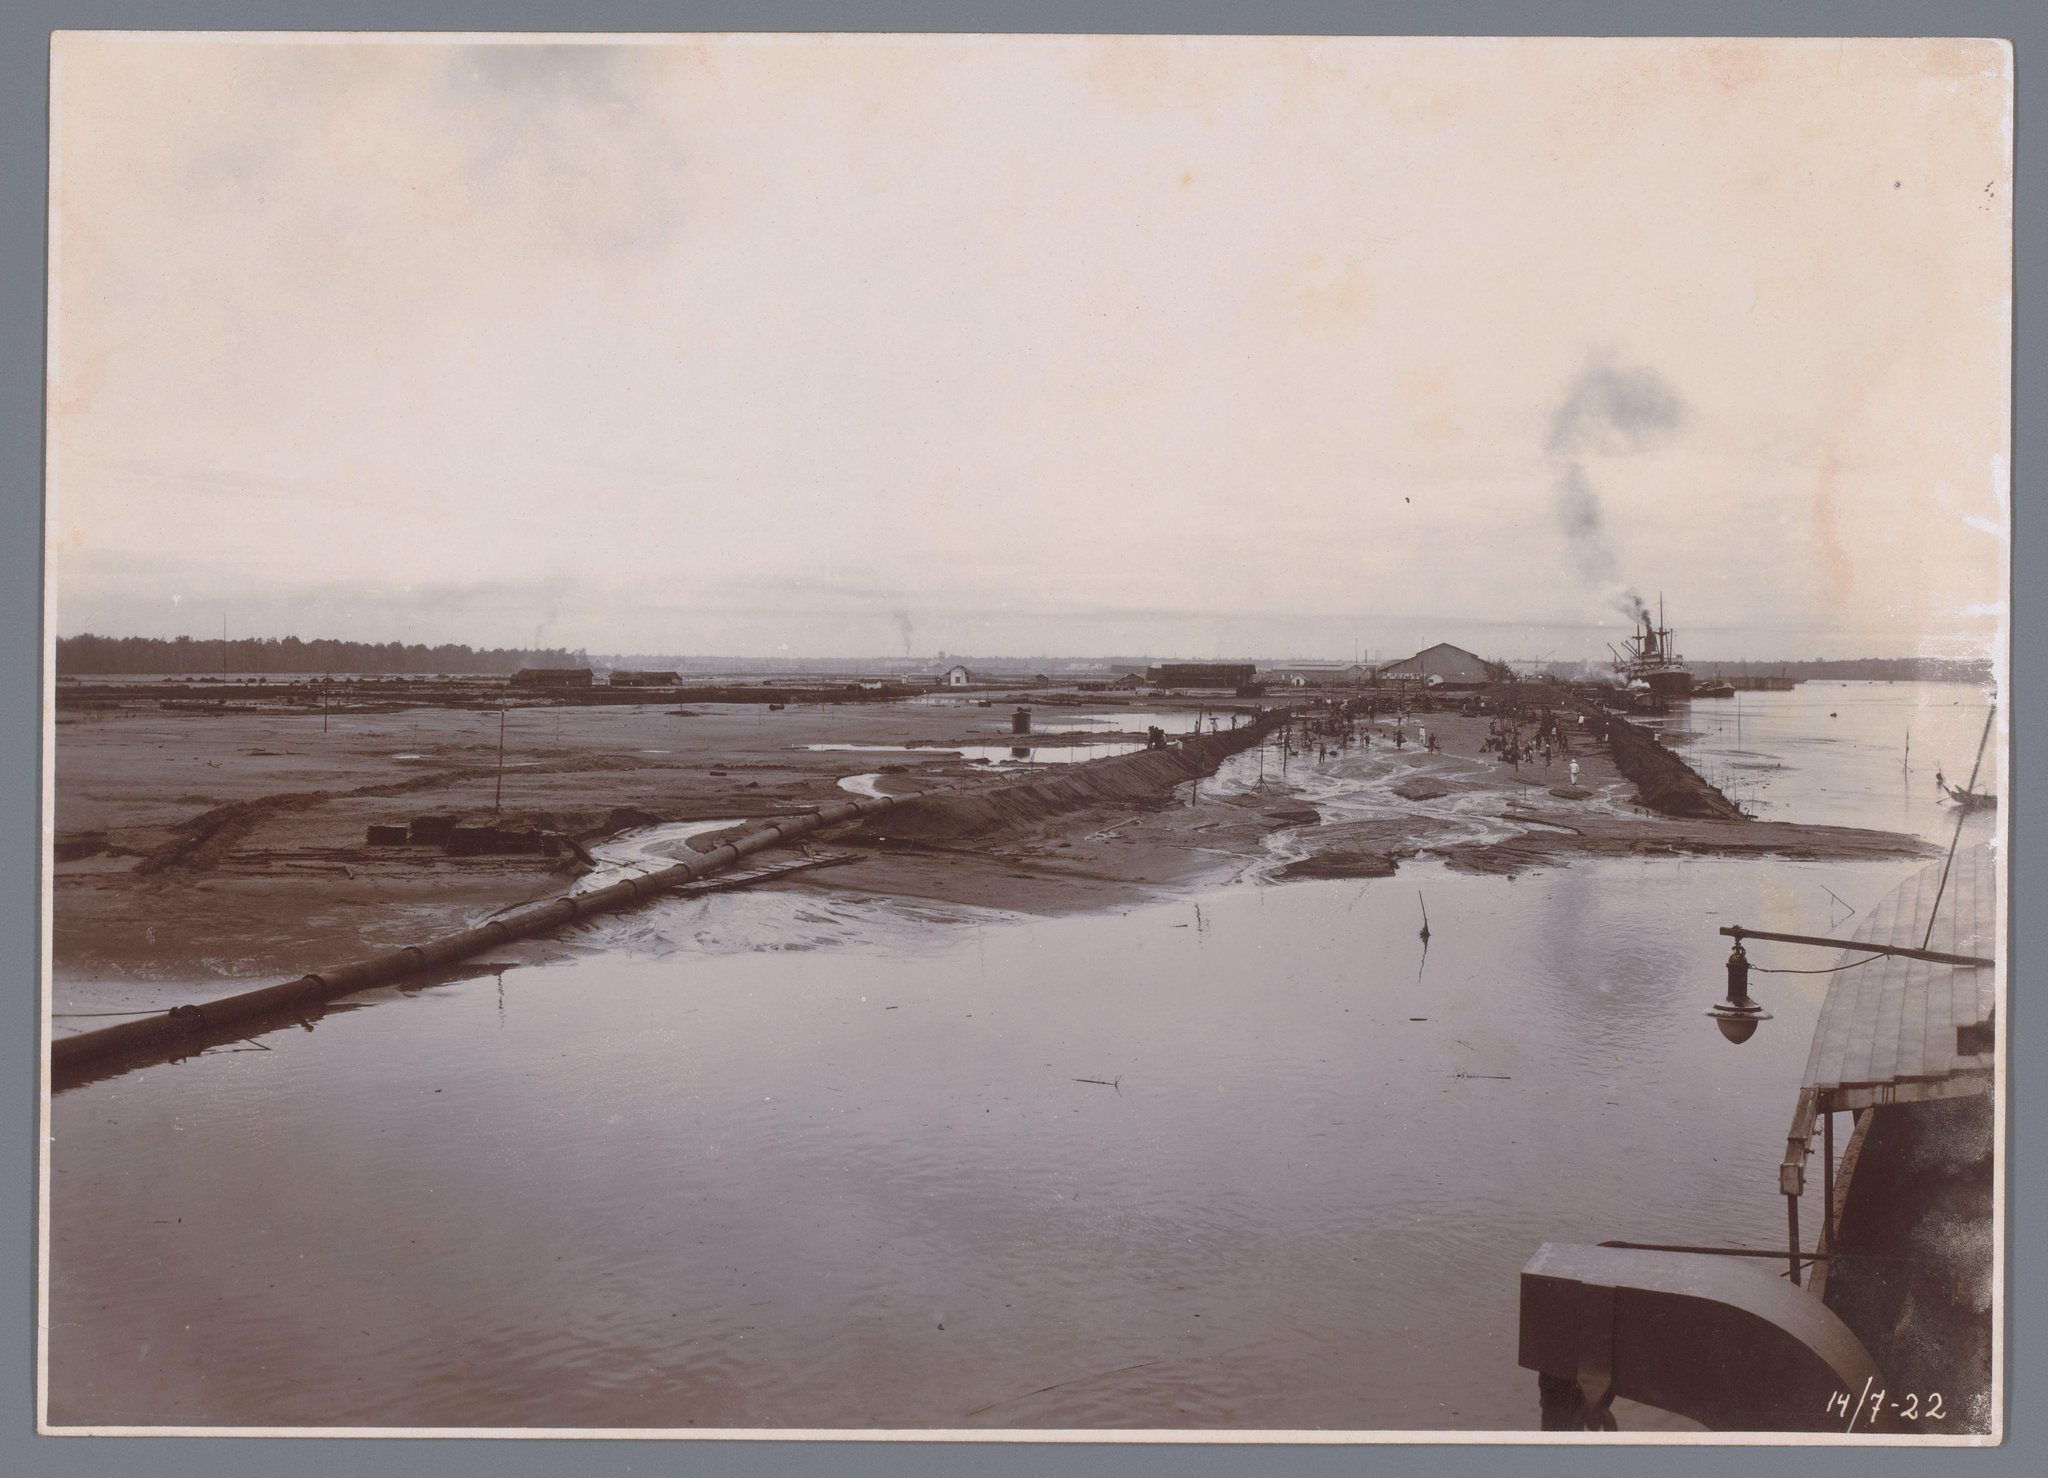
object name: photograph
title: Zand spuiten i/d grondverbetering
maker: Anonymous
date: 1922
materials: photographic support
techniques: gelatin silver print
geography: belawan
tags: harbour, building-site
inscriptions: date: ‘14/7-22’, annotation: ‘No. 180a / Zand spuiten i/d grondverbetering’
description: Gezicht op het bouwterrein met het opspuiten van elders gebaggerd zand op het terrein van de haven voor grondverbetering, juli 1922. Genummerd: 180a. Onderdeel van de groep van losse foto's over de aanleg van de haven Belawan aan de kust voor Medan, Sumatra 1921-1922.